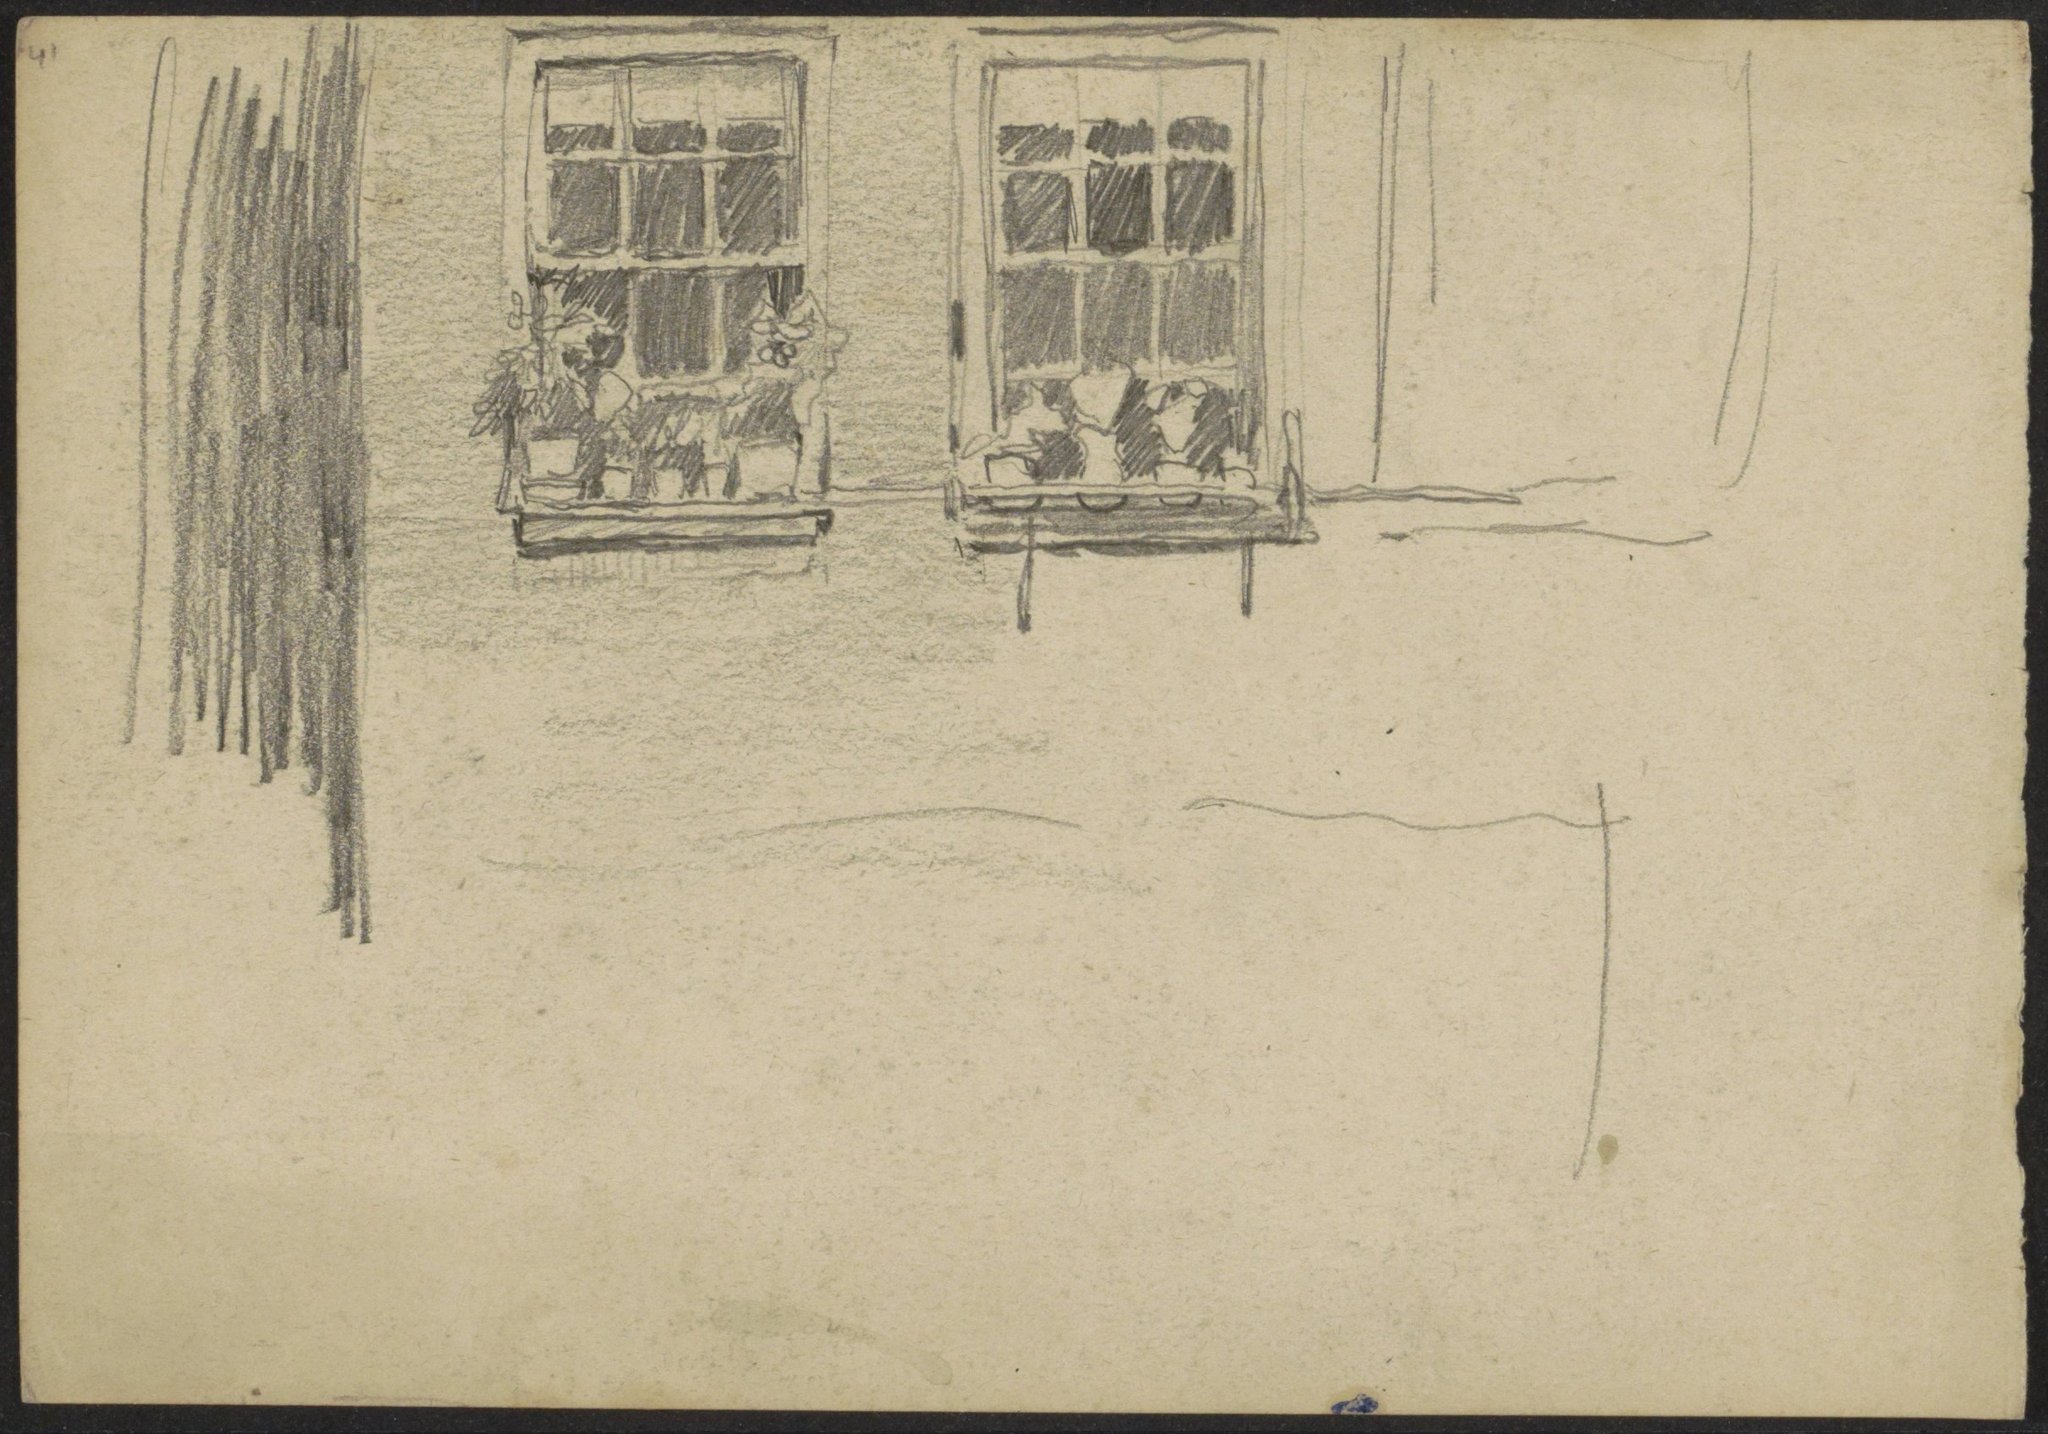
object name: sketchbook leaf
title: Twee ramen met bloempotten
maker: willem witsen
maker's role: draughtsman, painter, print maker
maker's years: 1860-1923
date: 1870-1923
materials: paper, pencil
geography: amsterdam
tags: urban housing, window, potted plants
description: Mogelijk de achterkant van de huizen aan de Zeedijk in Amsterdam, gezien vanaf de Oudezijds Achterburgwal.